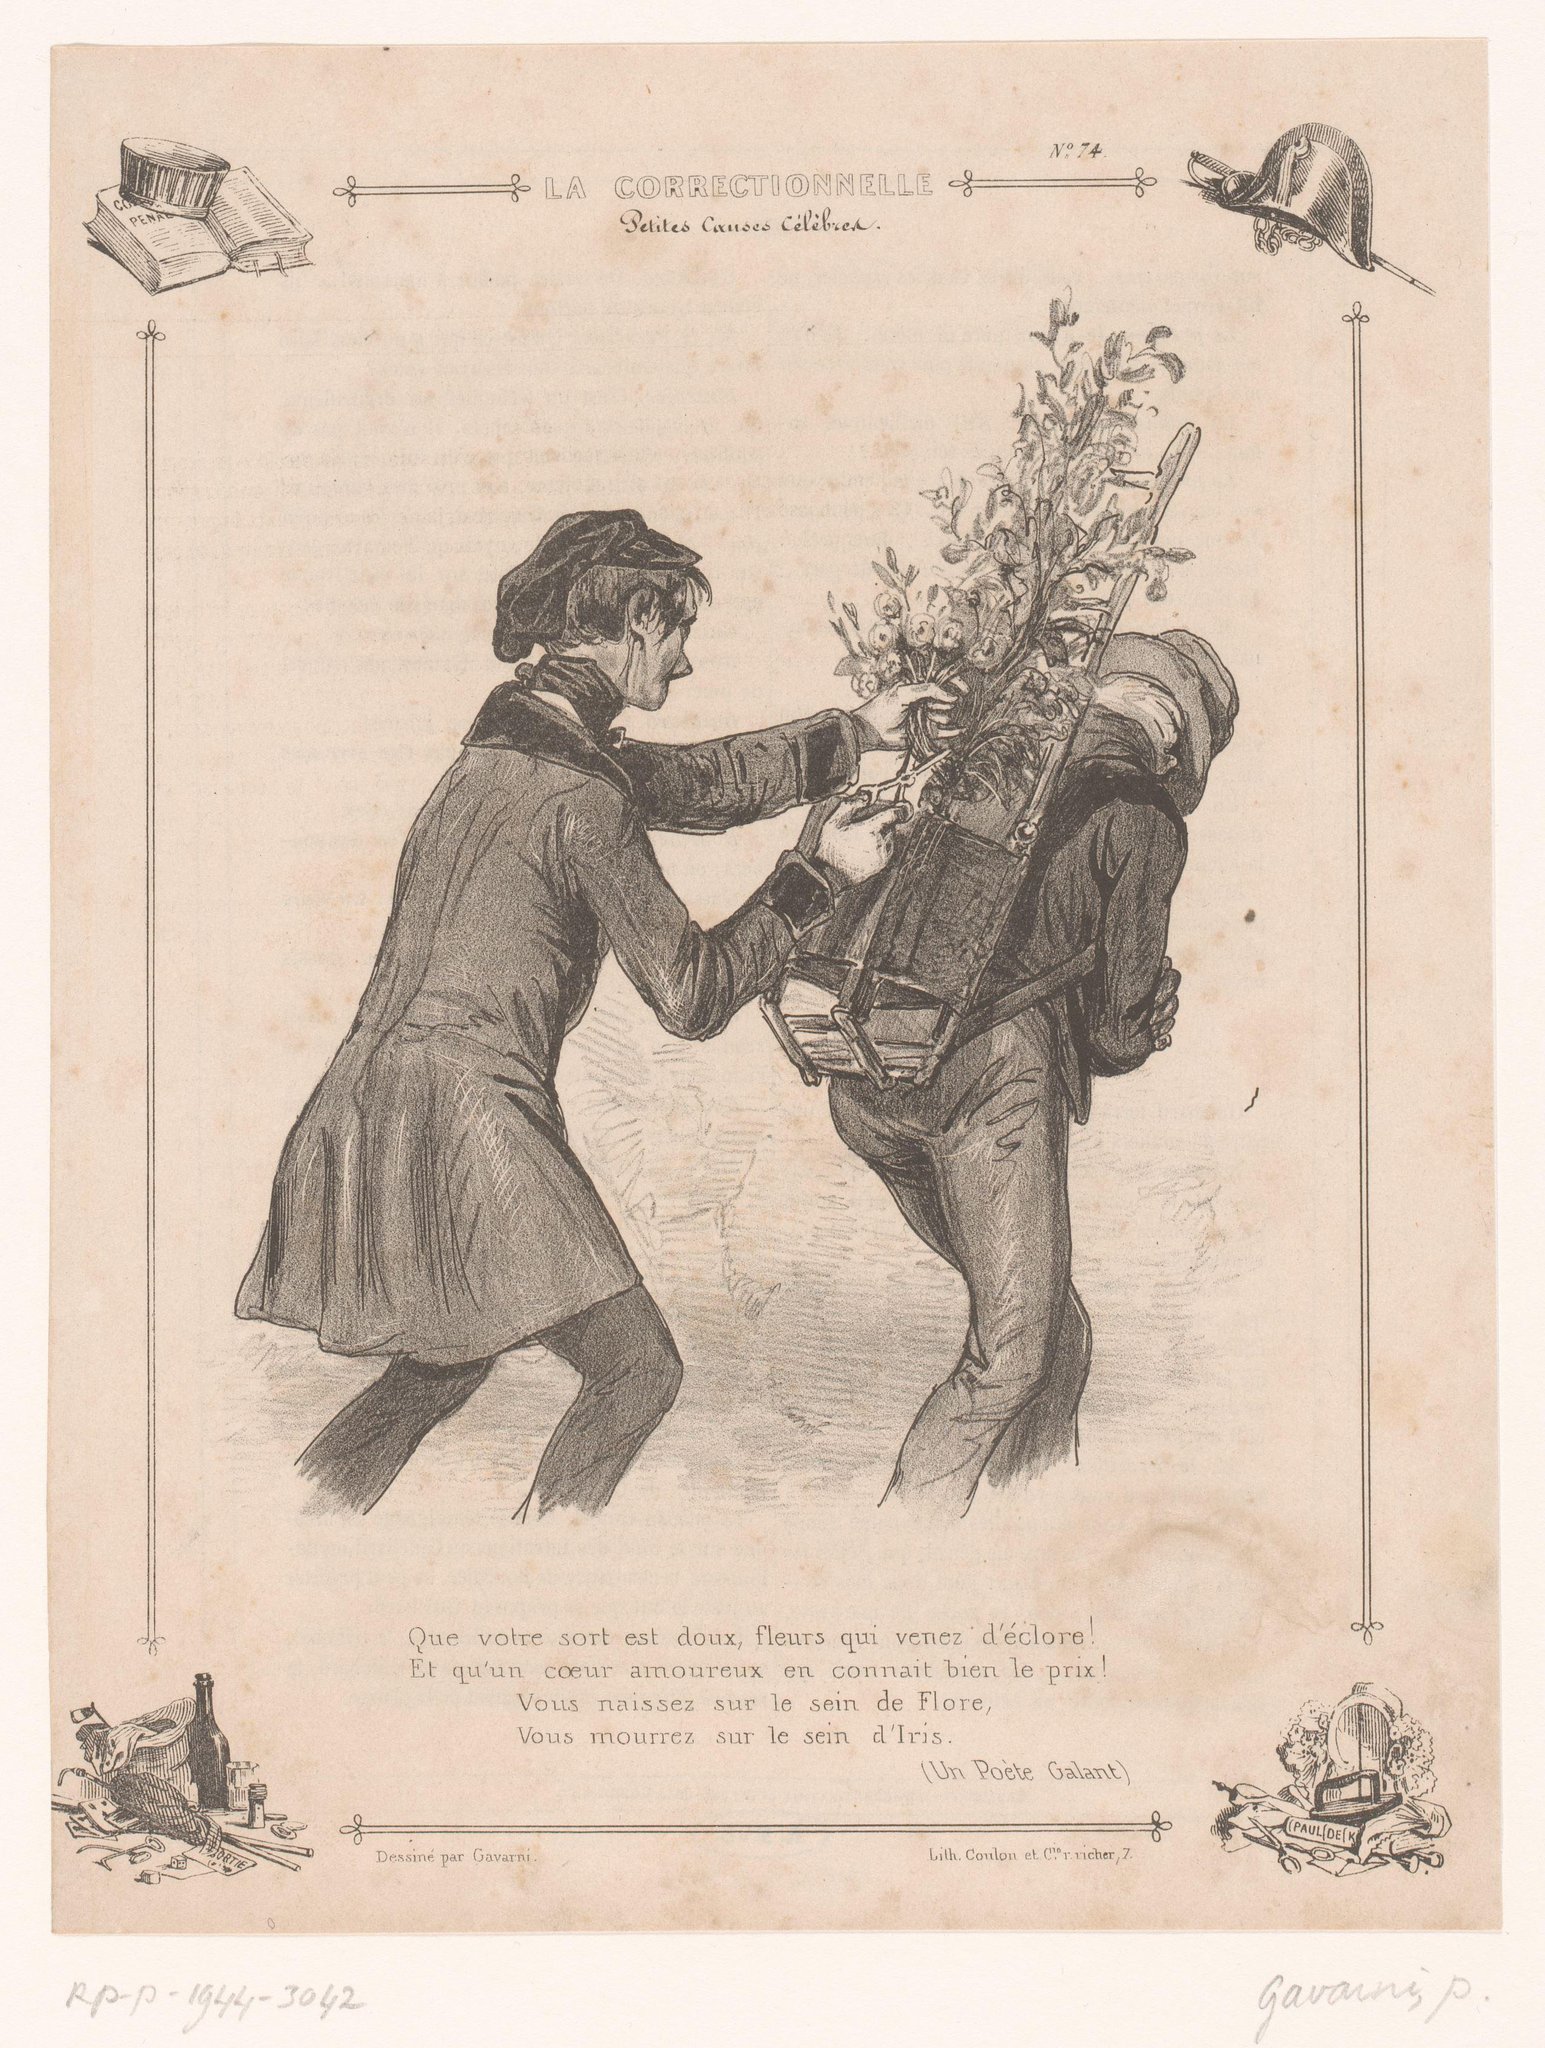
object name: book illustration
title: Que votre sort est doux (...)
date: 1840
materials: paper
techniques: lithograph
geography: paris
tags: cut flowers; nosegay, bunch of flowers, thief, merchant, salesman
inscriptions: collector's mark: Lugt 2228a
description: Prent gepubliceerd in: Gavarni, P. La Correctionnelle. Petites causes célèbres. Études de moeurs populaires au dix-neuvième siècle. Parijs: Martinon, 1840, p. 295.